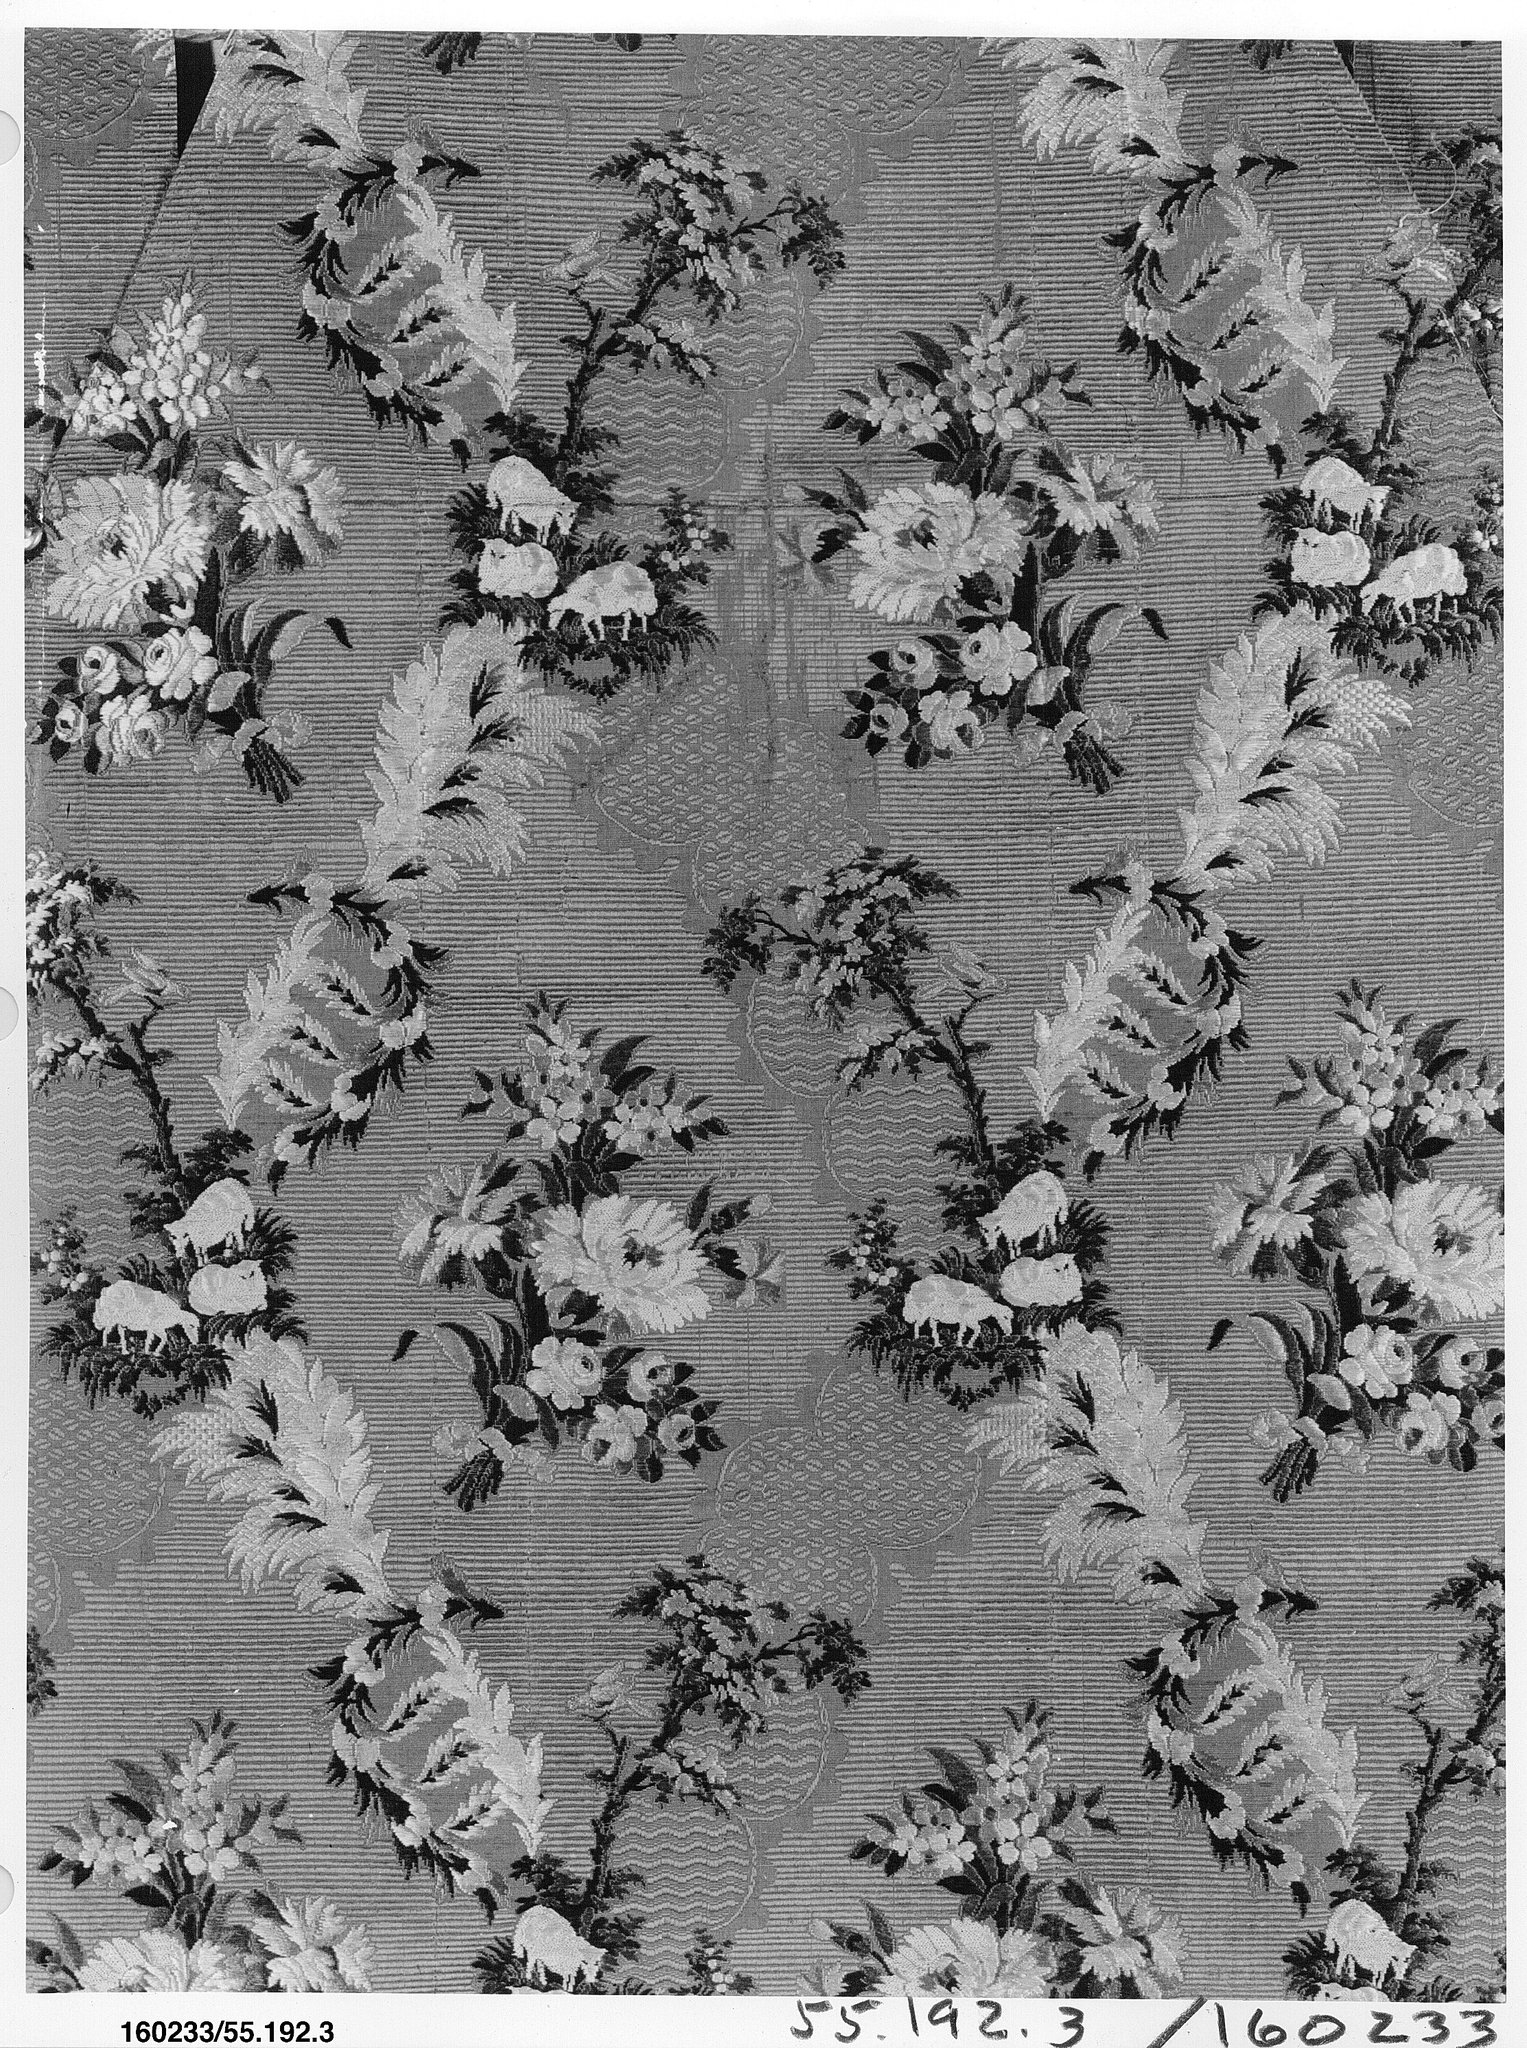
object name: panel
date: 1750-1760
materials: silk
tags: flowers